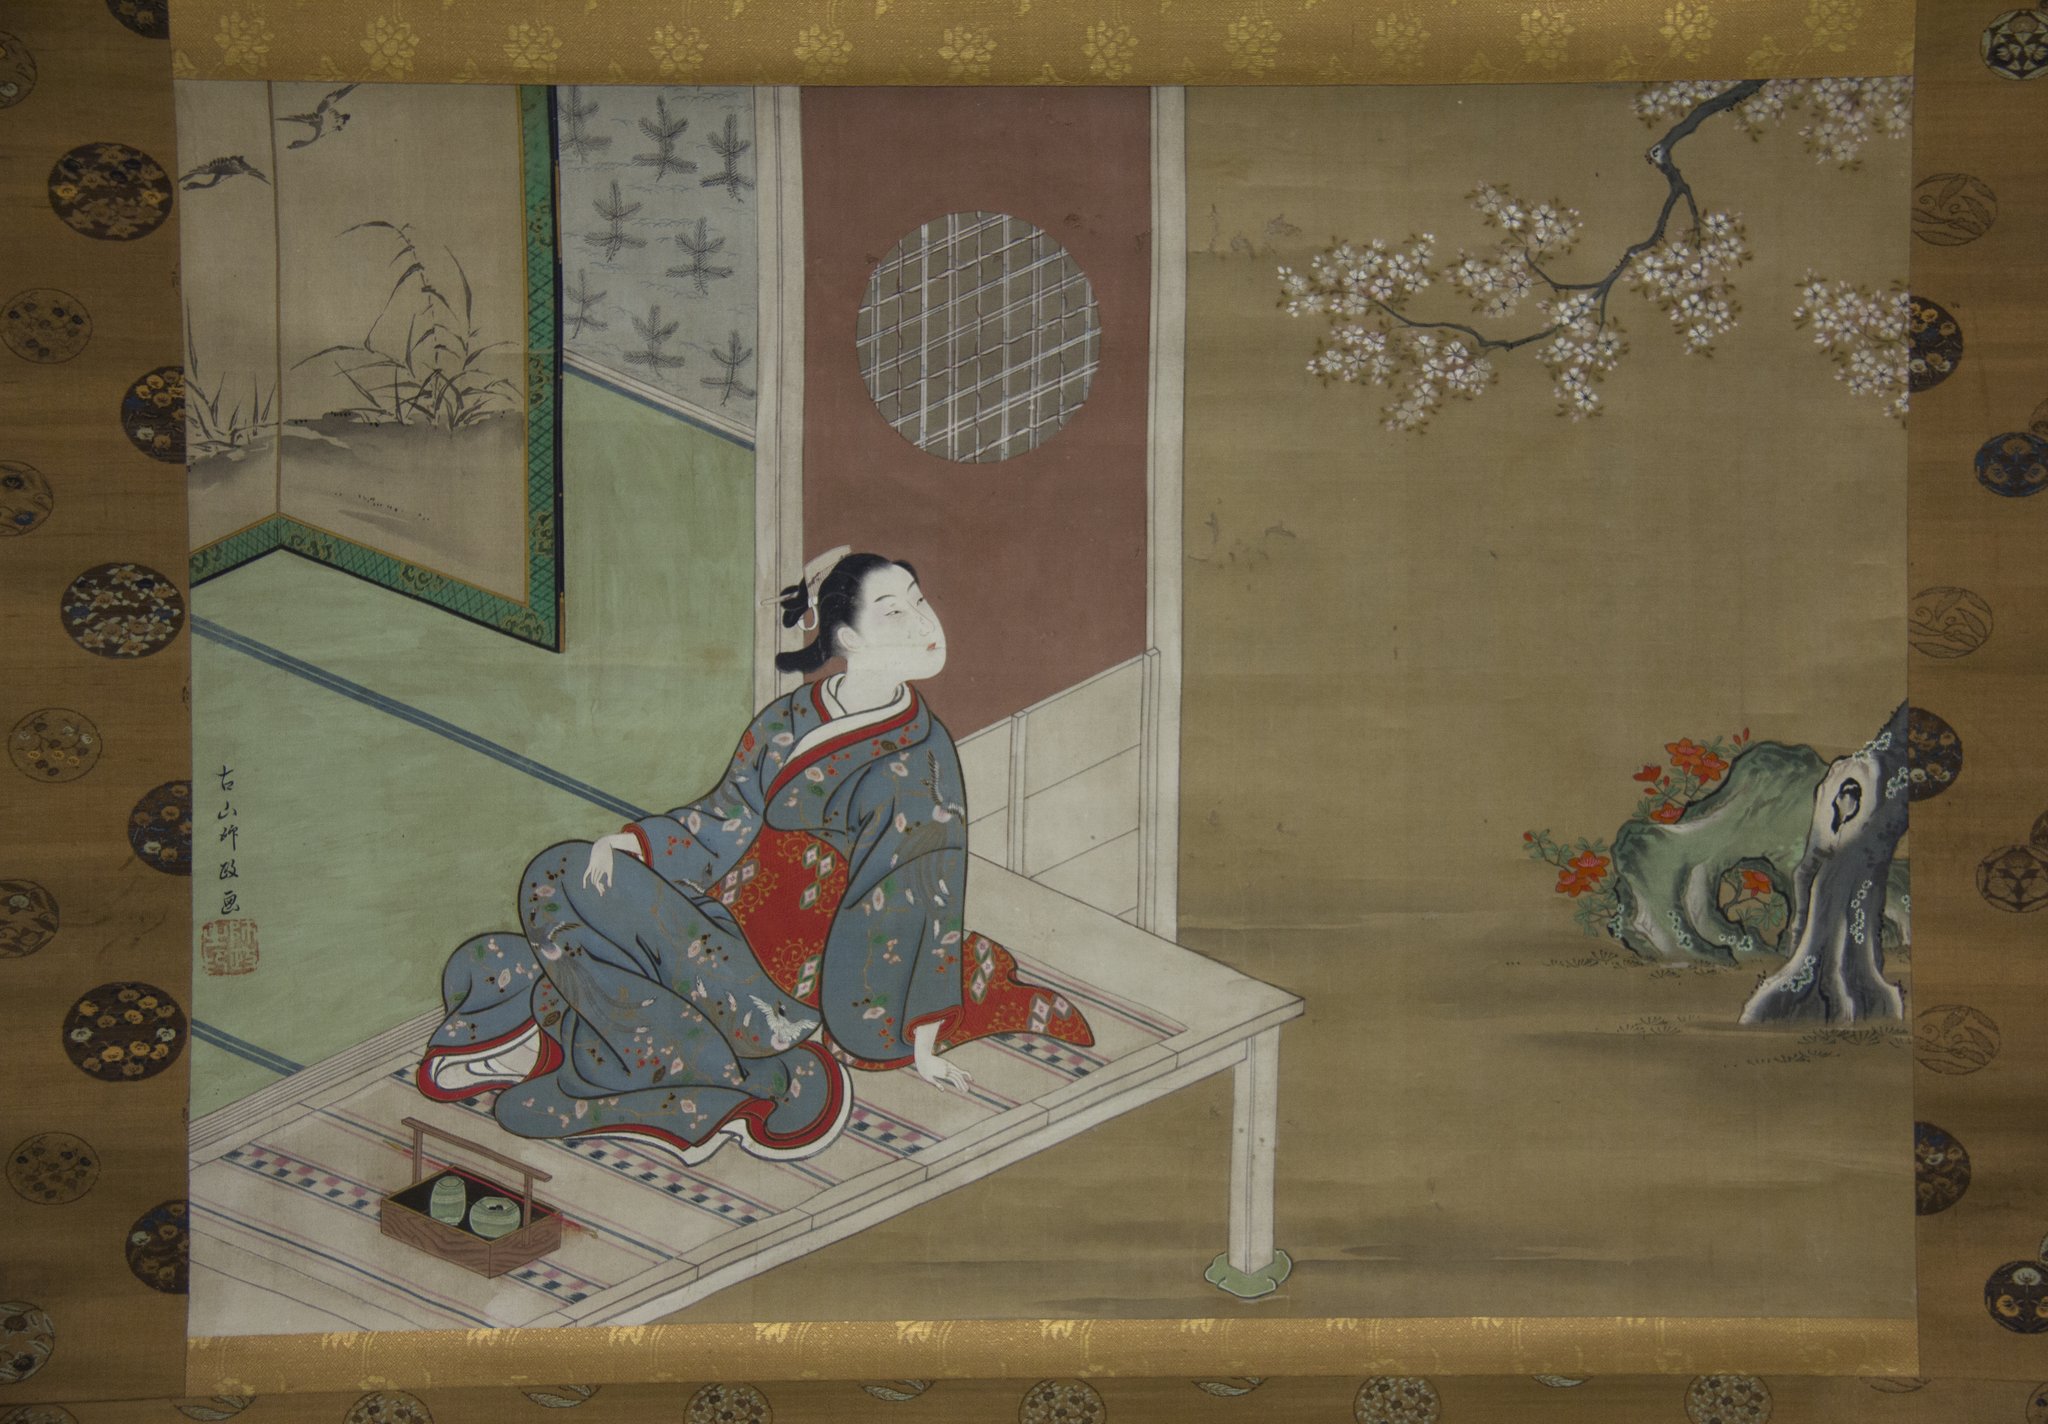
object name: hanging scroll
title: Courtesan Resting on the Veranda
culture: japanese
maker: furuyama moromasa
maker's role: artist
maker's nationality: japanese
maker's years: 1712-1772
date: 1701-1800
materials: ink, silk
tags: women